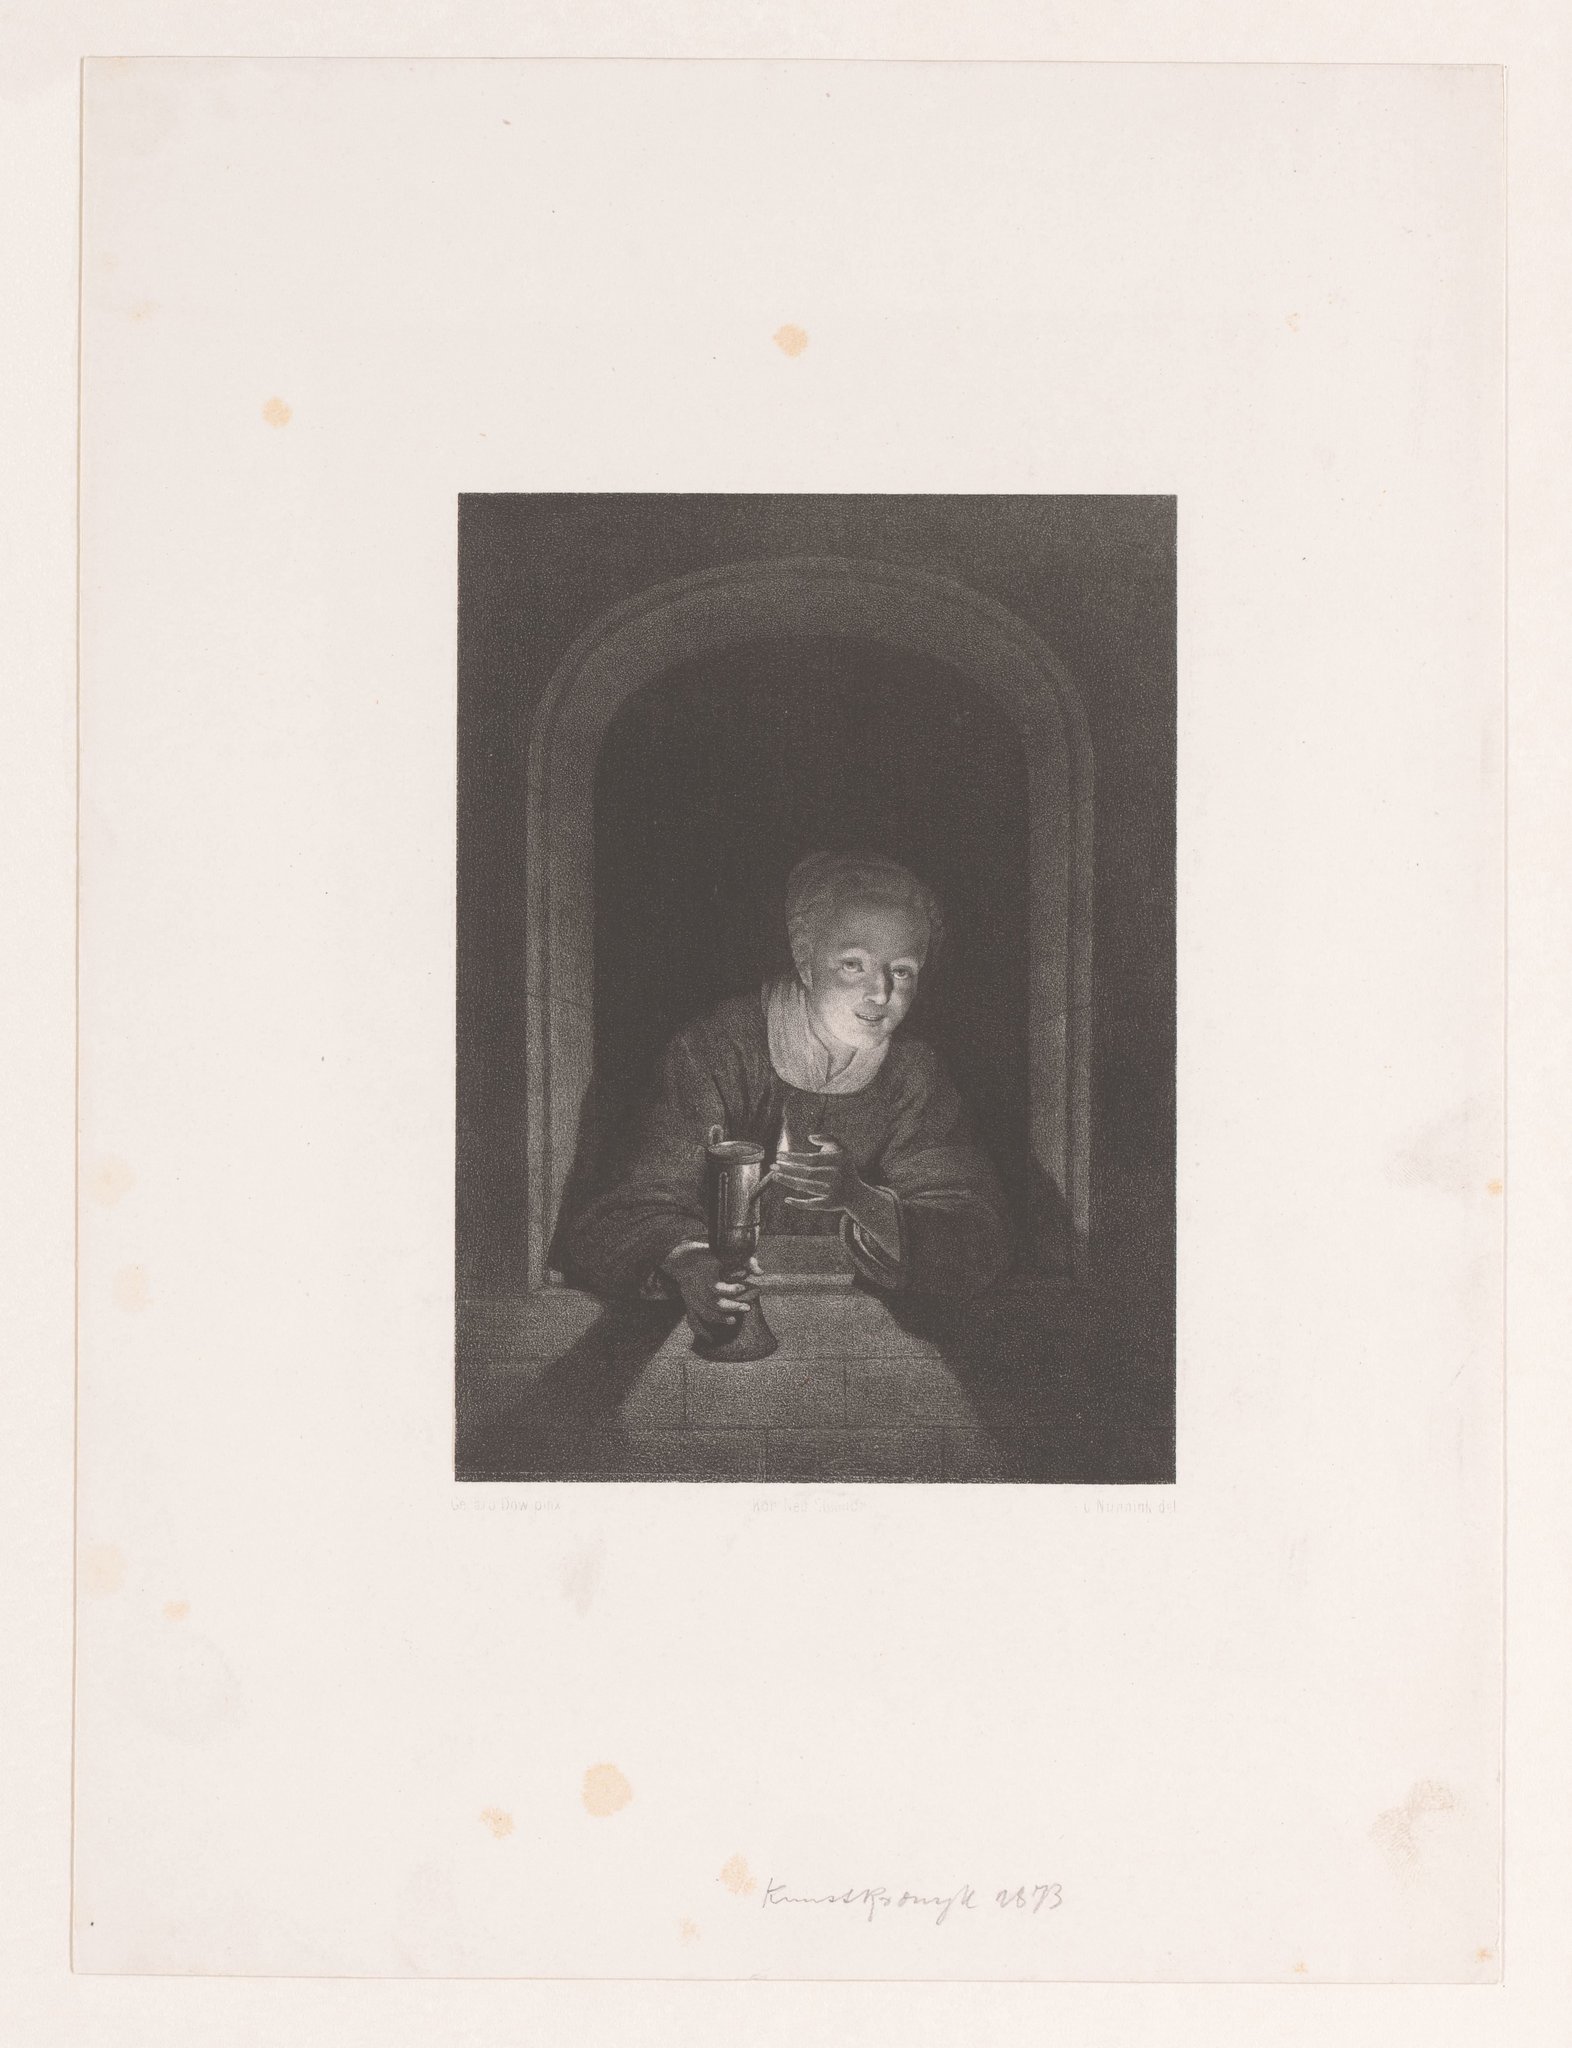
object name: print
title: Vrouw met een olielamp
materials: paper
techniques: lithograph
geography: the hague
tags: oil-lamp, human figure at (open) window, seen from outside - aa - feigned window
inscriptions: collector's mark: Lugt 2228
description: Een jonge vrouw leunt met een brandende olielamp uit een venster.